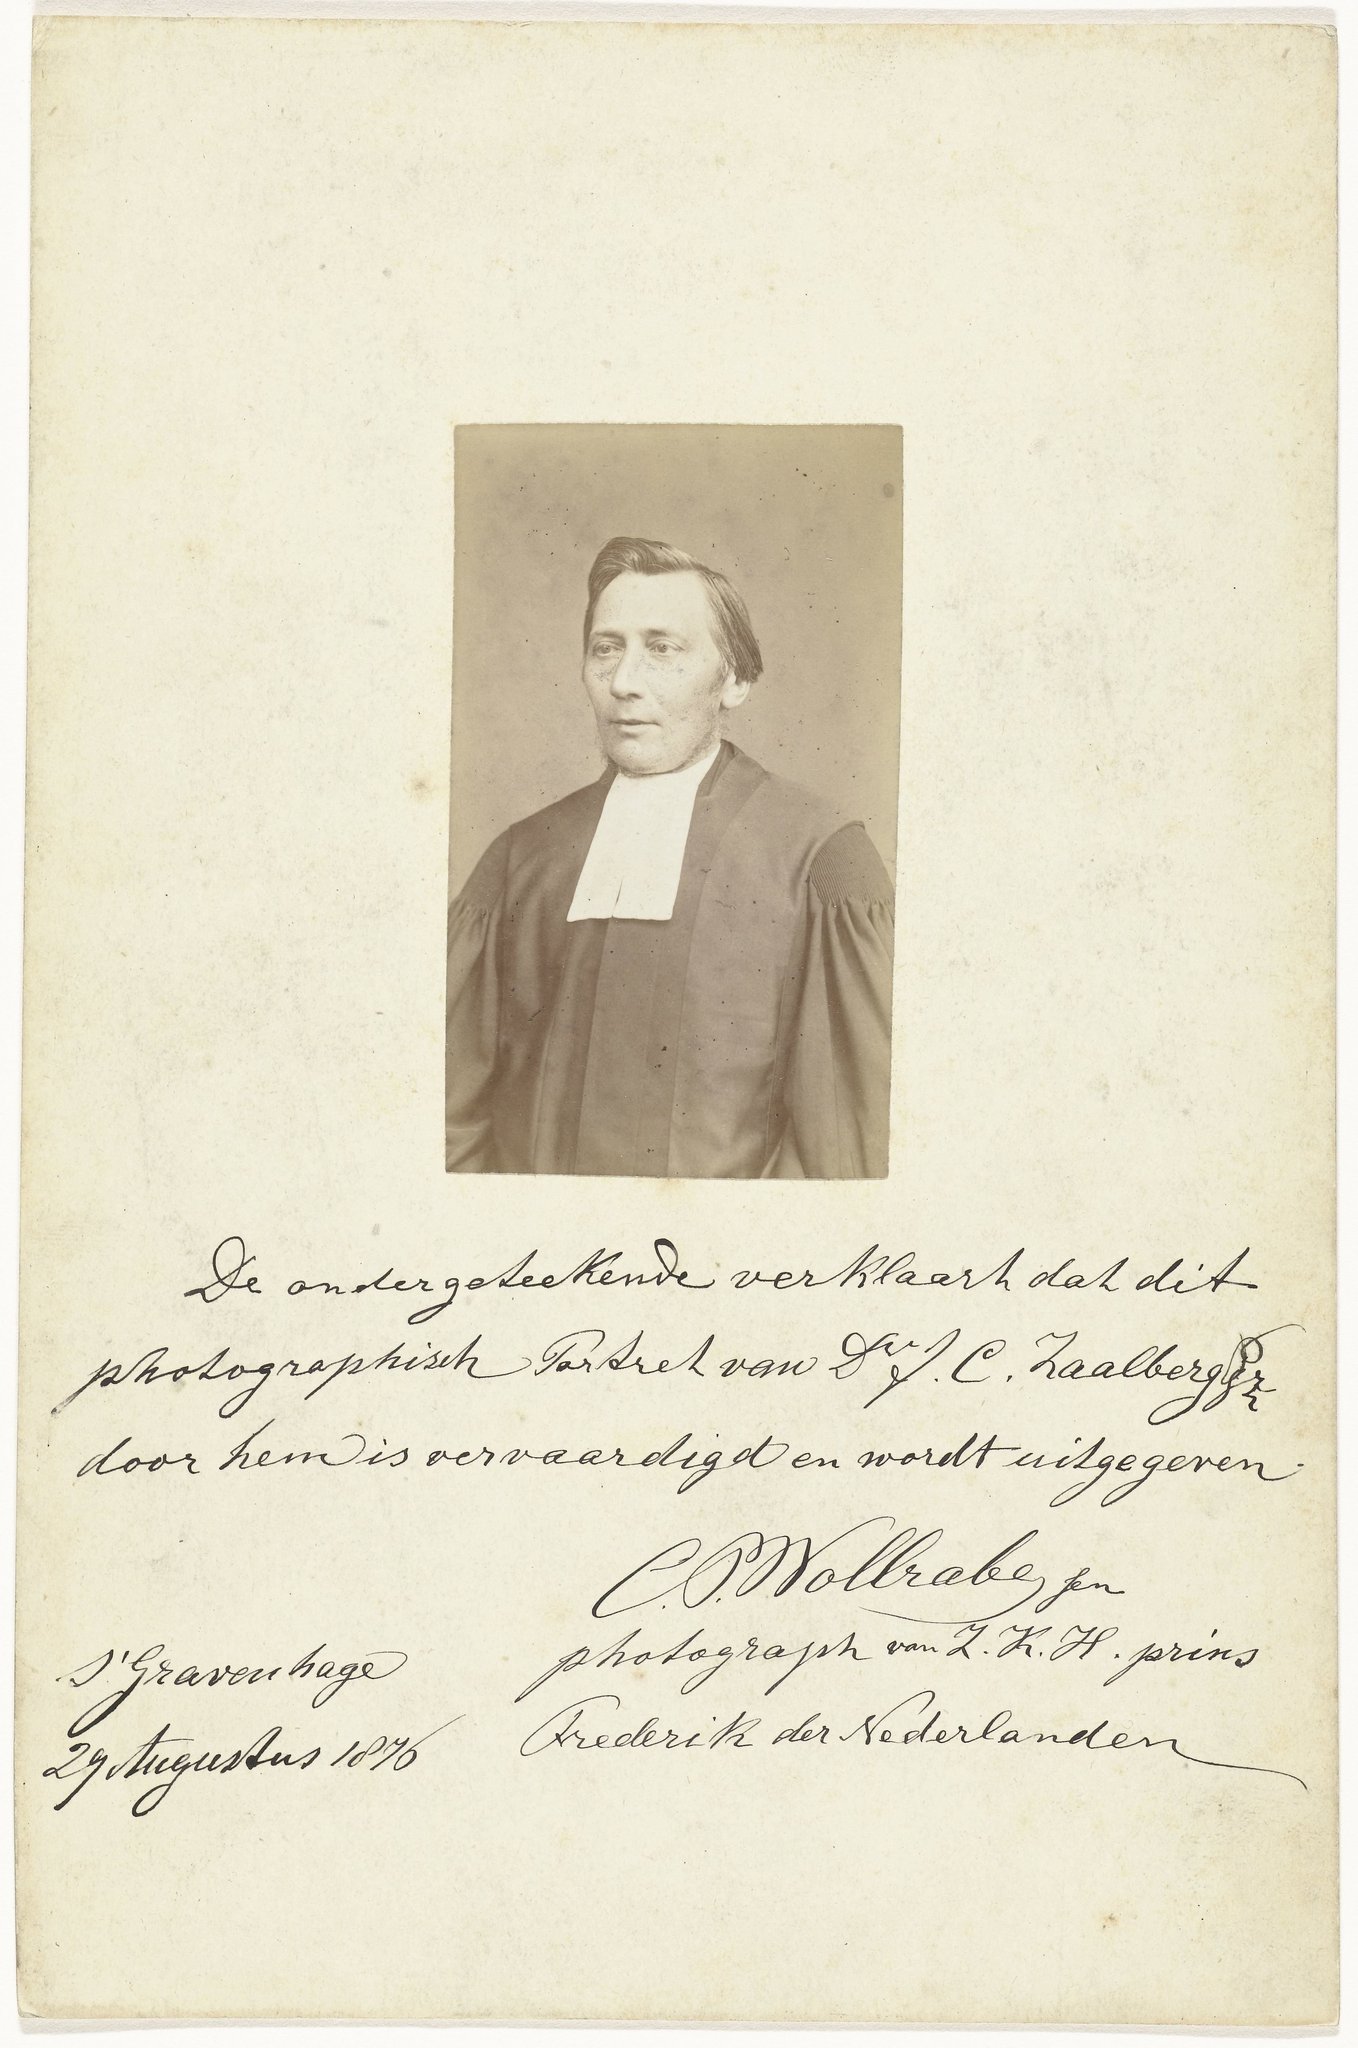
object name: photograph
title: Portret van Dr. Johannes Cornelis Zaalberg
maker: carl philip wollrabe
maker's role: fotograaf, musicus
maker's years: 1812-1887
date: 1876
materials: cardboard, paper, photographic support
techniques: albumen print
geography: the hague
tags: historical persons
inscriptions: signature: ‘De ondergeteekende verklaart dat dit photographisch portret van D.F.C. Zaalberg door hem is vervaardigd en wordt uitgegeven. C.P. Wollrabe photograph van Z.K.H. prins Frederik der Nederlanden 's Gravenhage 29 augustus 1876’